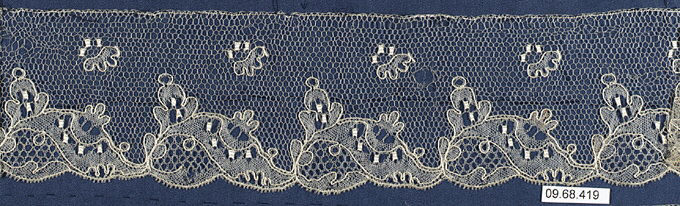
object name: bobbin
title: Silk bobbin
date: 1801-1900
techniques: lace